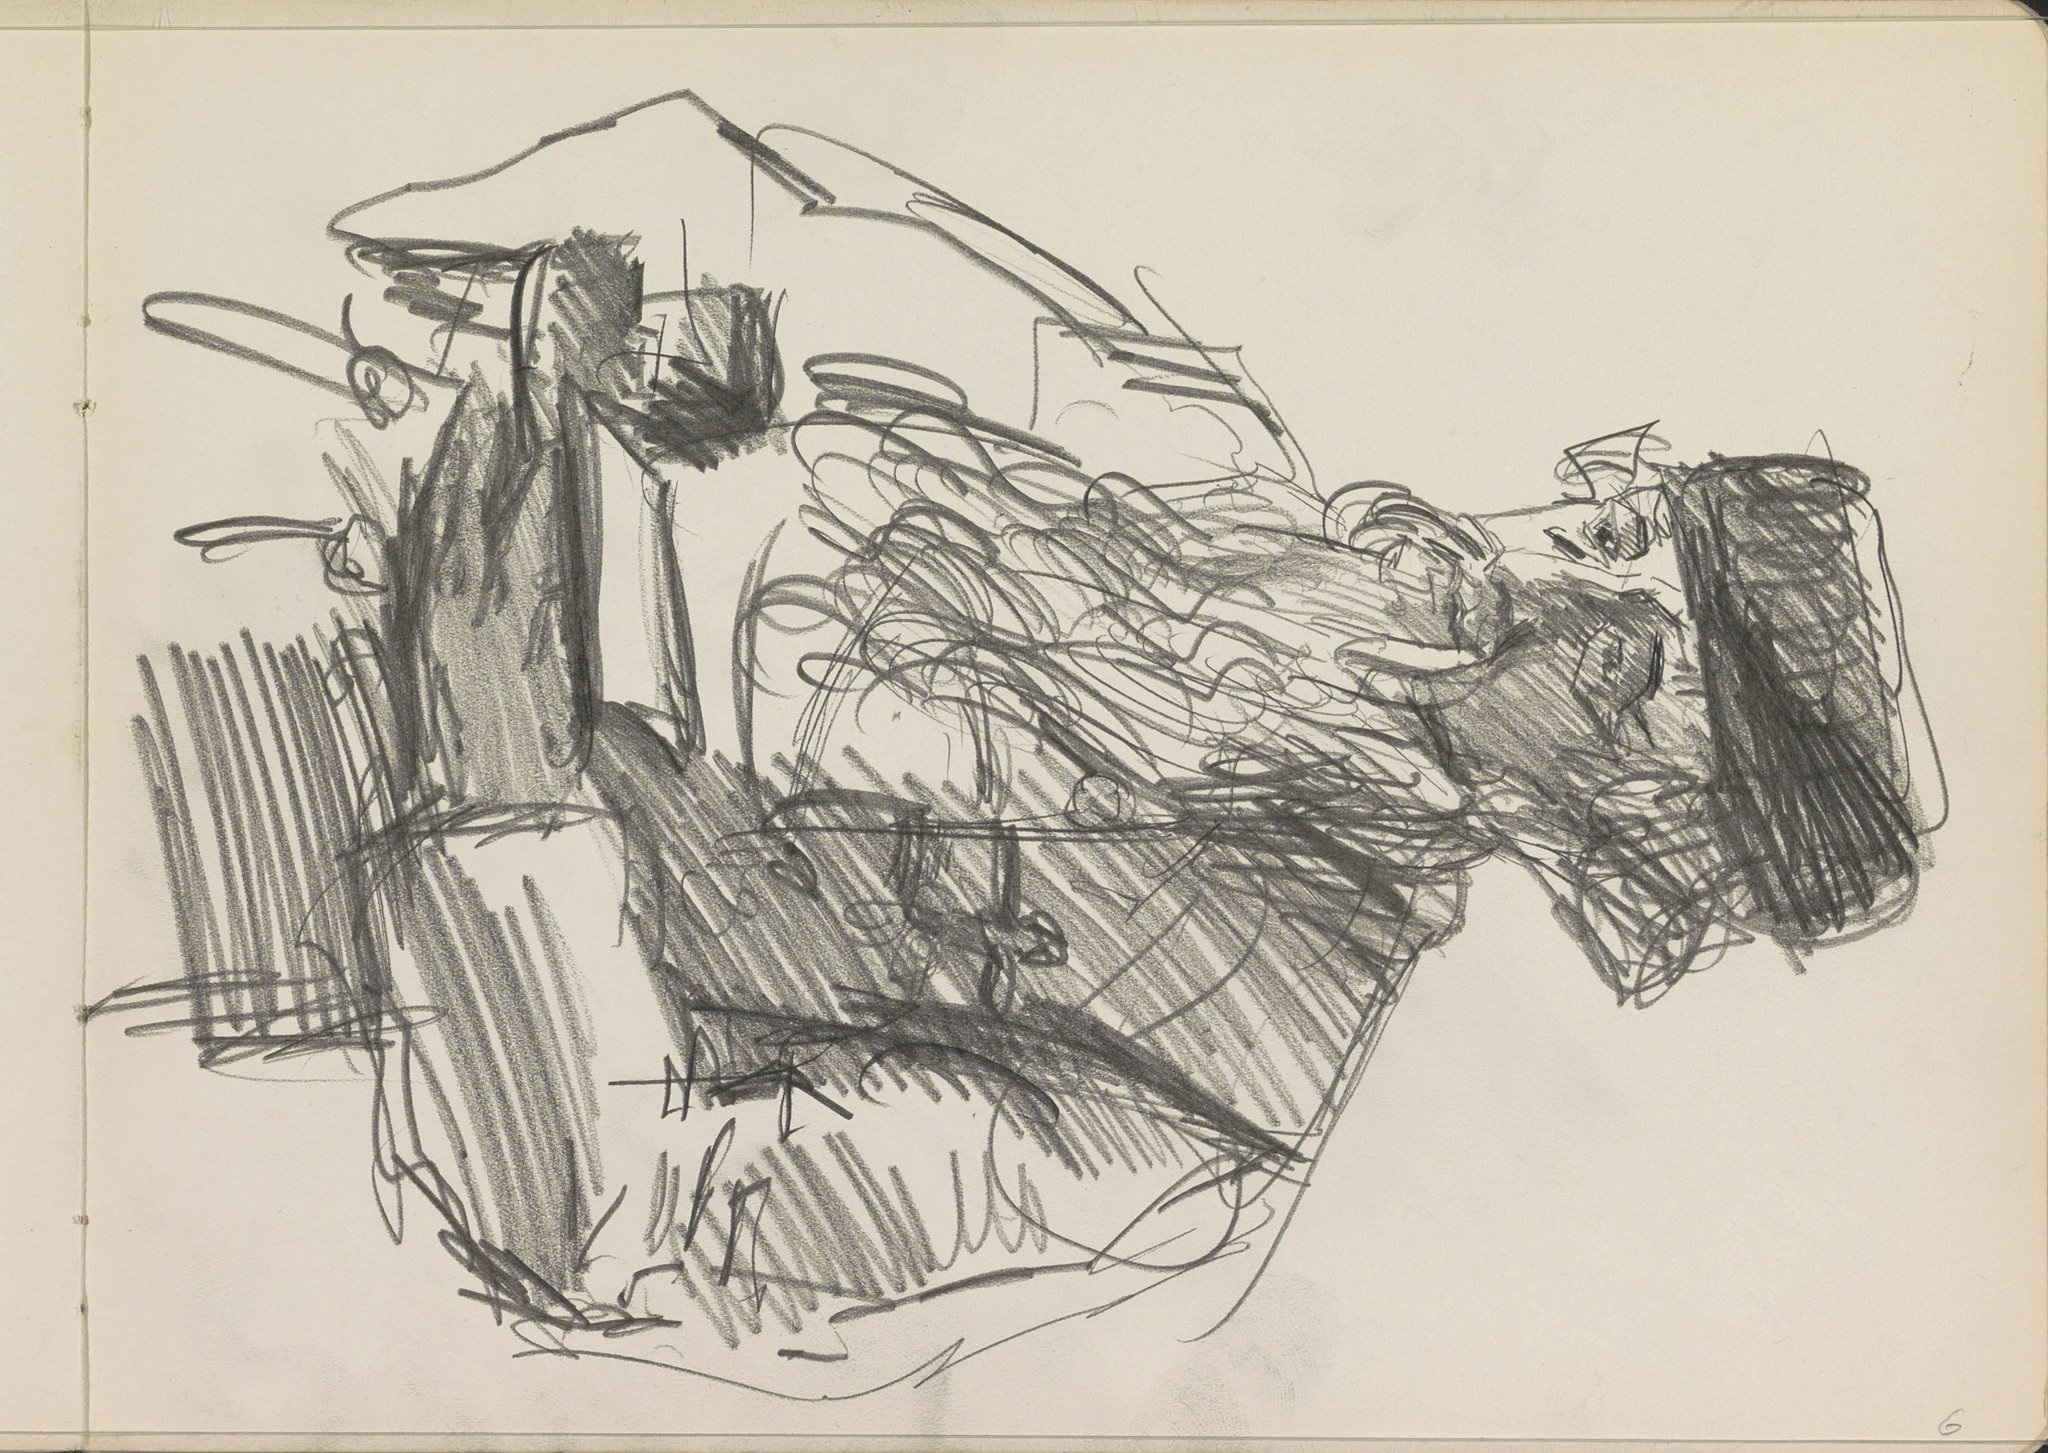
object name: sketchbook leaf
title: Man met baard en baret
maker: isaac israels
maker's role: draughtsman, painter, print maker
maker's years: 1865-1934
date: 1915-1934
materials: paper, pencil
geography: the hague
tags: head-gear, beard (+ male human being (not to be used where -a- is prescribed))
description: Blad 6 recto uit schetsboek VI met 33 bladen.